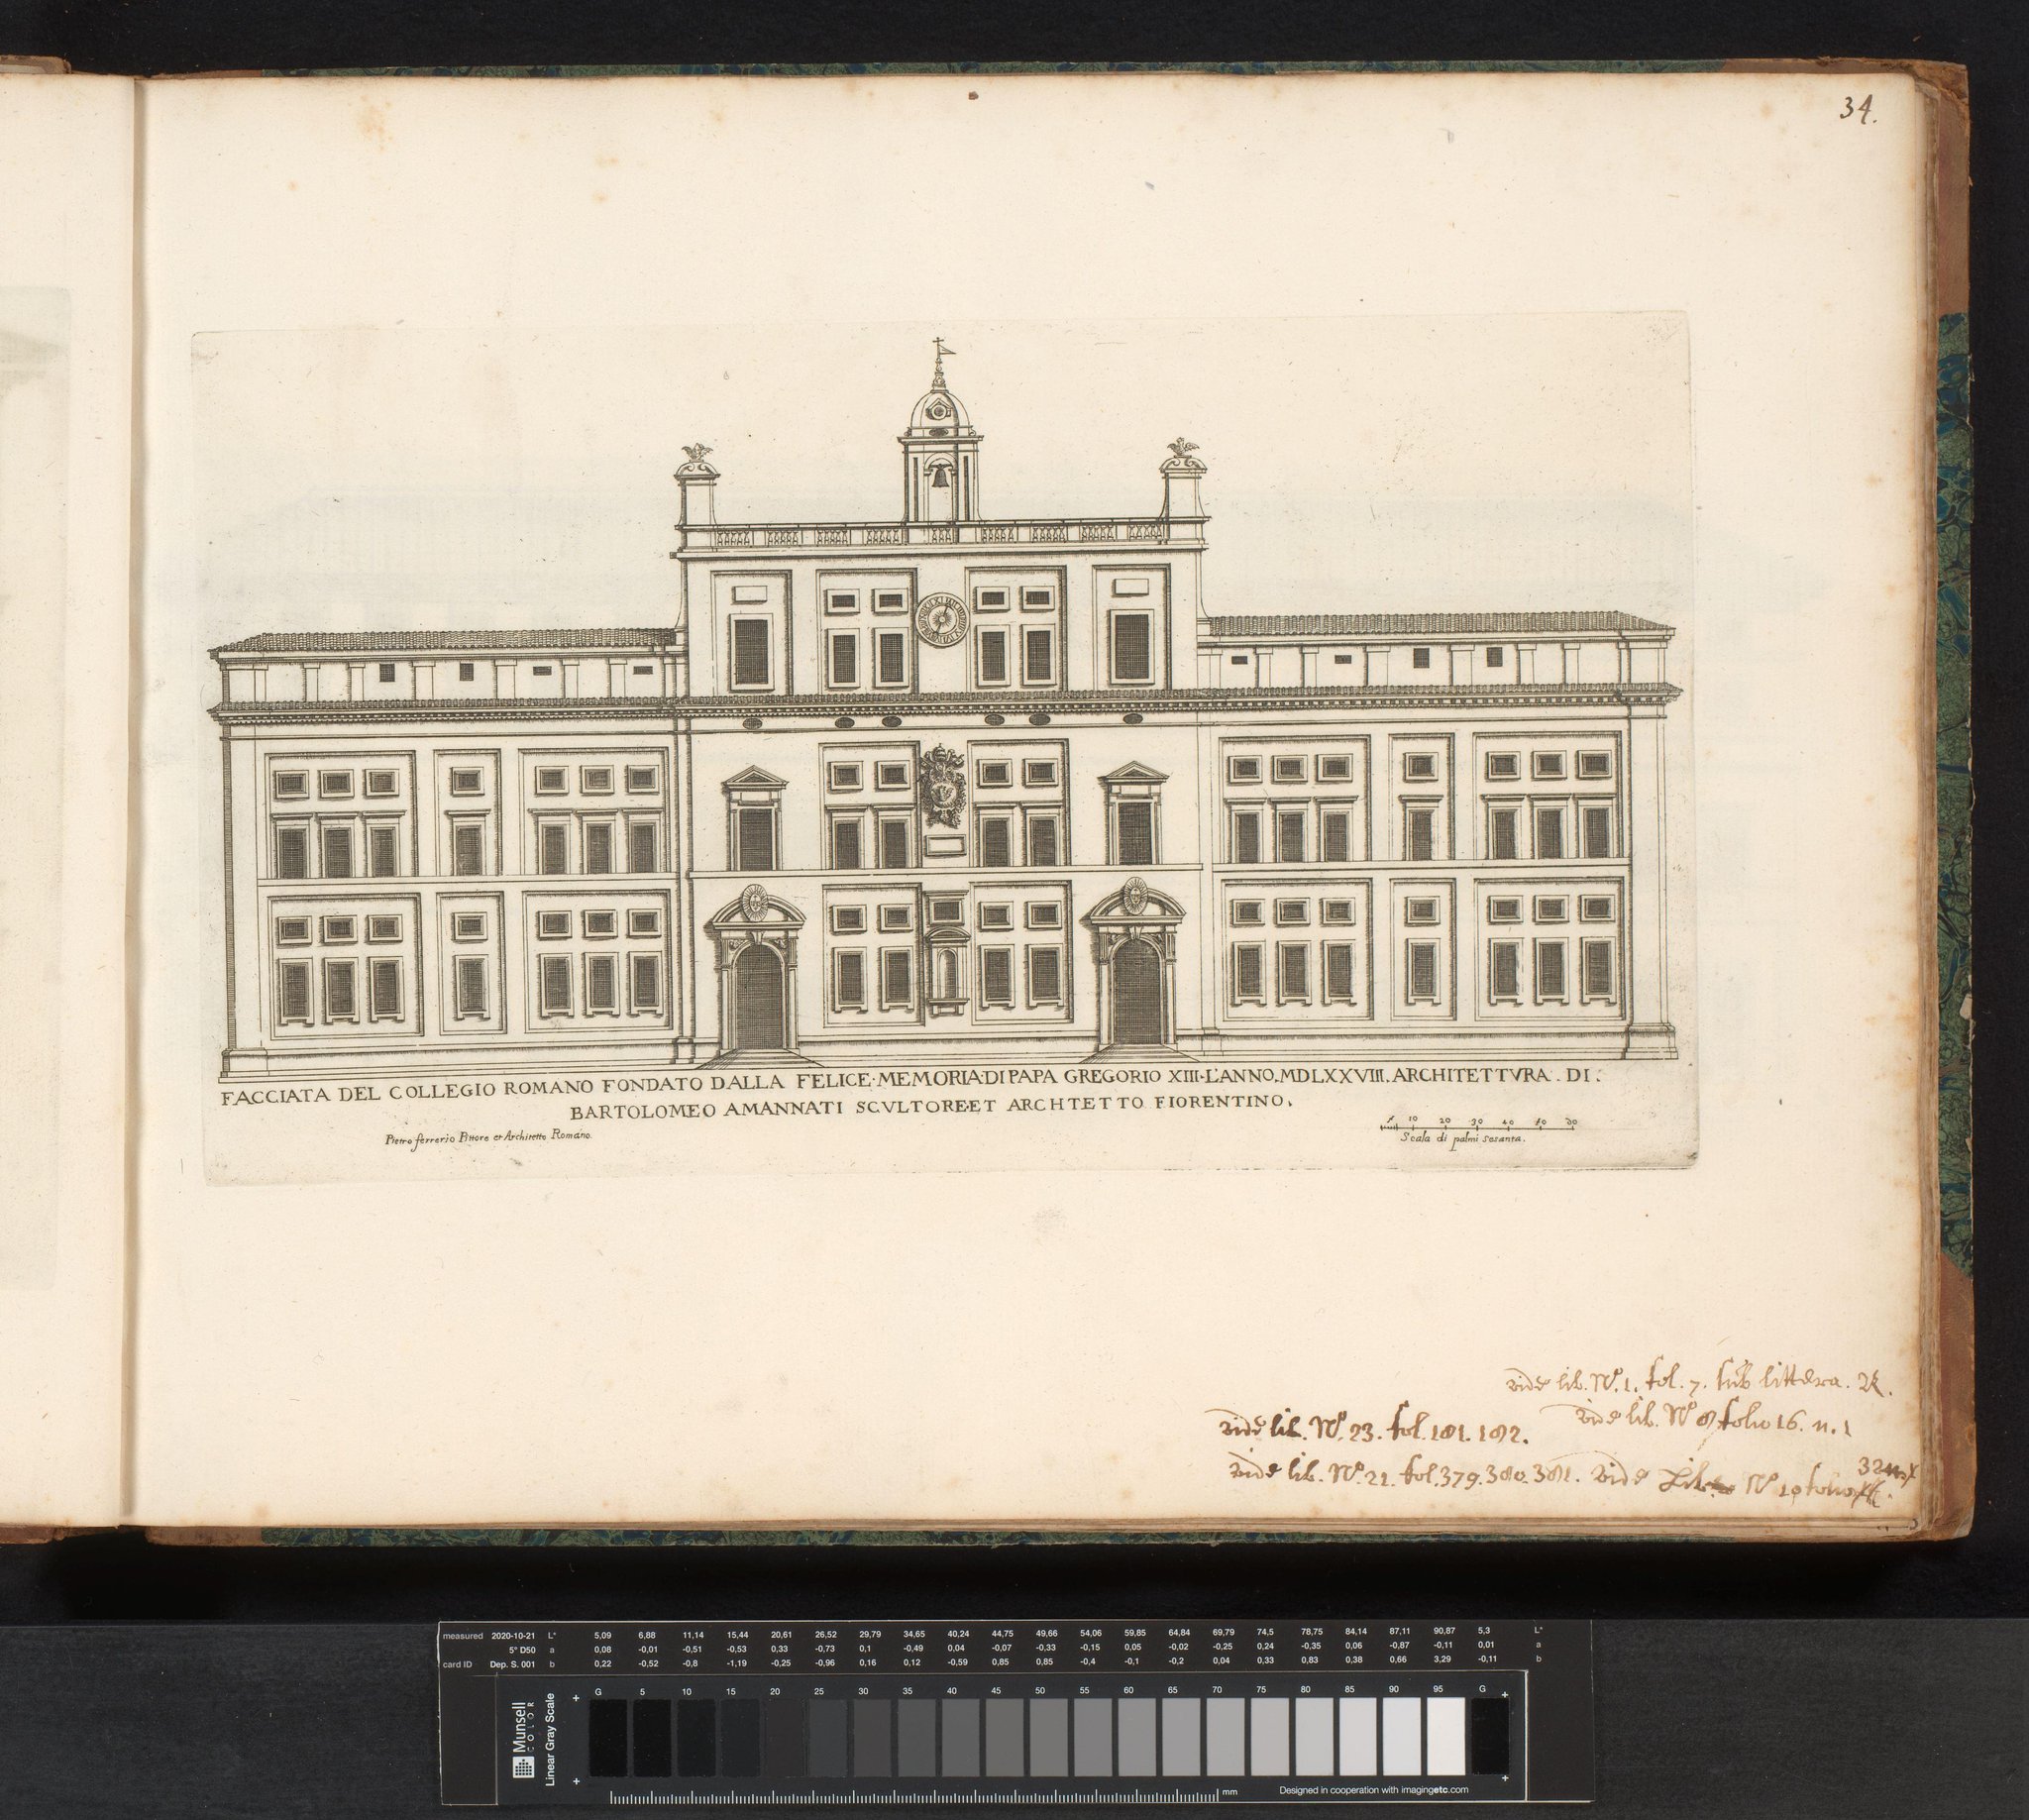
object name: album leaf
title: Facciata del Collegio Romano fondato dalla felice memoria di papa Gregorio XII (...)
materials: paper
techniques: etching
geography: italy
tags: gregorius xiii, palace, façade (of house or building)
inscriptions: inscription: ‘Ende lib. No. 23. fol. 181. 182...’, number: ‘34’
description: Deze prent maakt deel uit van de reeks getiteld: Palazzi di Roma. Deze reeks bestaat uit twee boeken. Boek één getiteld: Palazzi di Roma dei più celebri architetti..., bestaat uit 44 prenten die worden toegeschreven aan Giovanni Battista Falda (naam staat enkel op prent 27) en uitgegeven door Giovanni Giacomo de'Rossi. Deze 44 prenten zijn bekend in twee staten (met en zonder nummer). Boek twee getiteld: Nuovi disegni dell'architetture... libro secondo, bevat 66 prenten door Giovanni Battista Falda en Simone Felice. Deze 66 prenten zijn bekend in twee staten (met en zonder nummer).